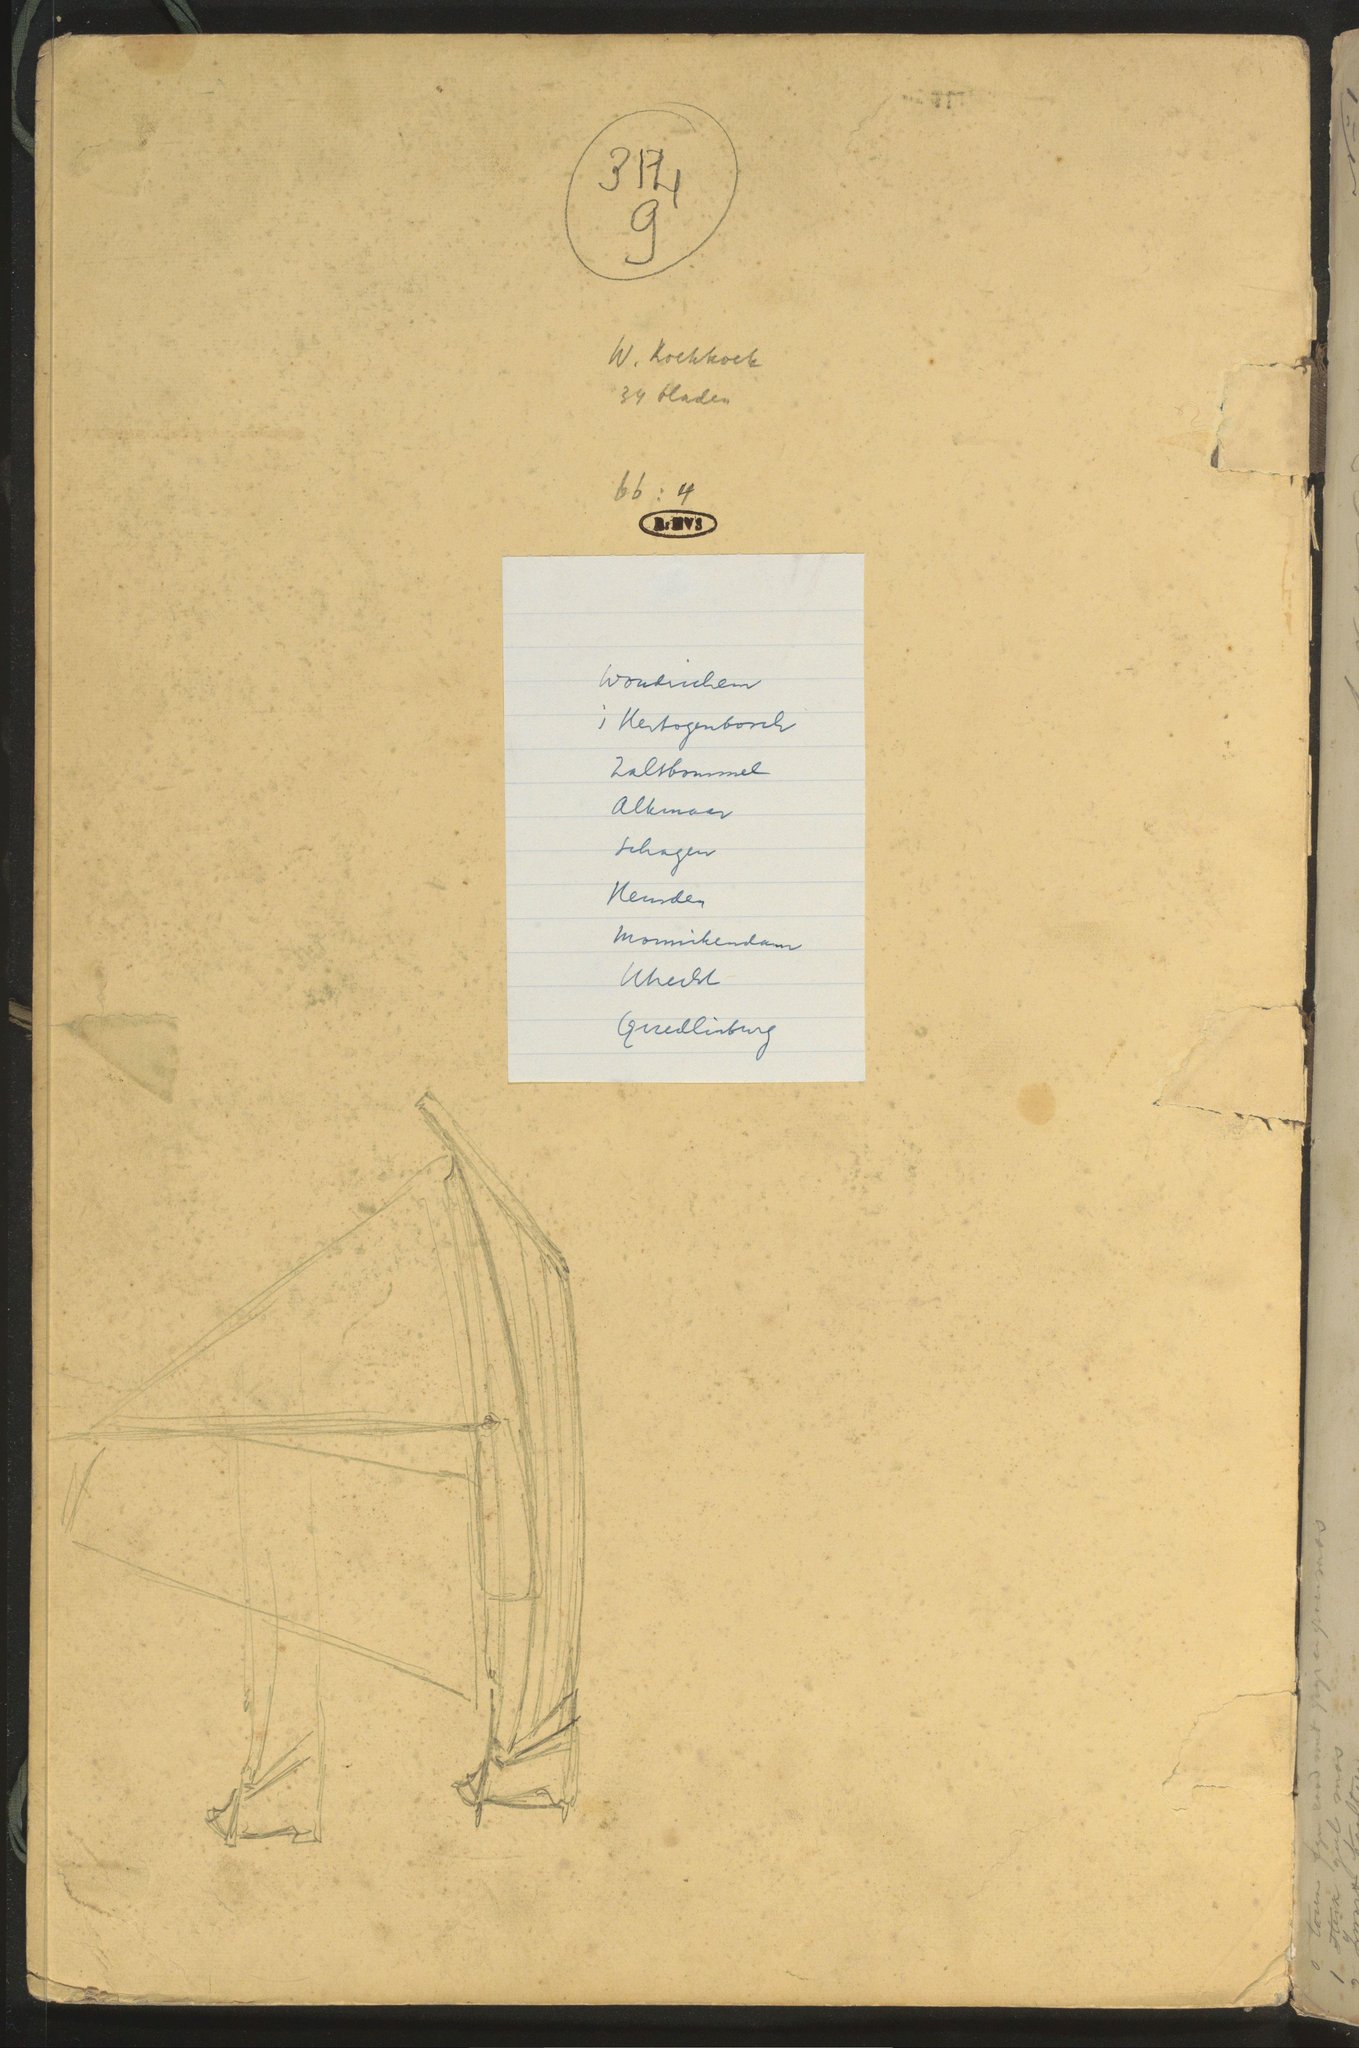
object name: endleaf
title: Zeilboten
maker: willem koekkoek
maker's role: draughtsman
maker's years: 1839-1895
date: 1849-1895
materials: paper, pencil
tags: sailing-ship, sailing-boat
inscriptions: annotation: ‘Woudrichem/ 's Hertogenbosch/ Zaltbommel/ Alkmaar/ Schagen/ Heusden/ Monnickendam/ Utrecht/Quellinburg’, collector's mark: Lugt 2228a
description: Voorste schutblad uit een schetsboek met 35 bladen.